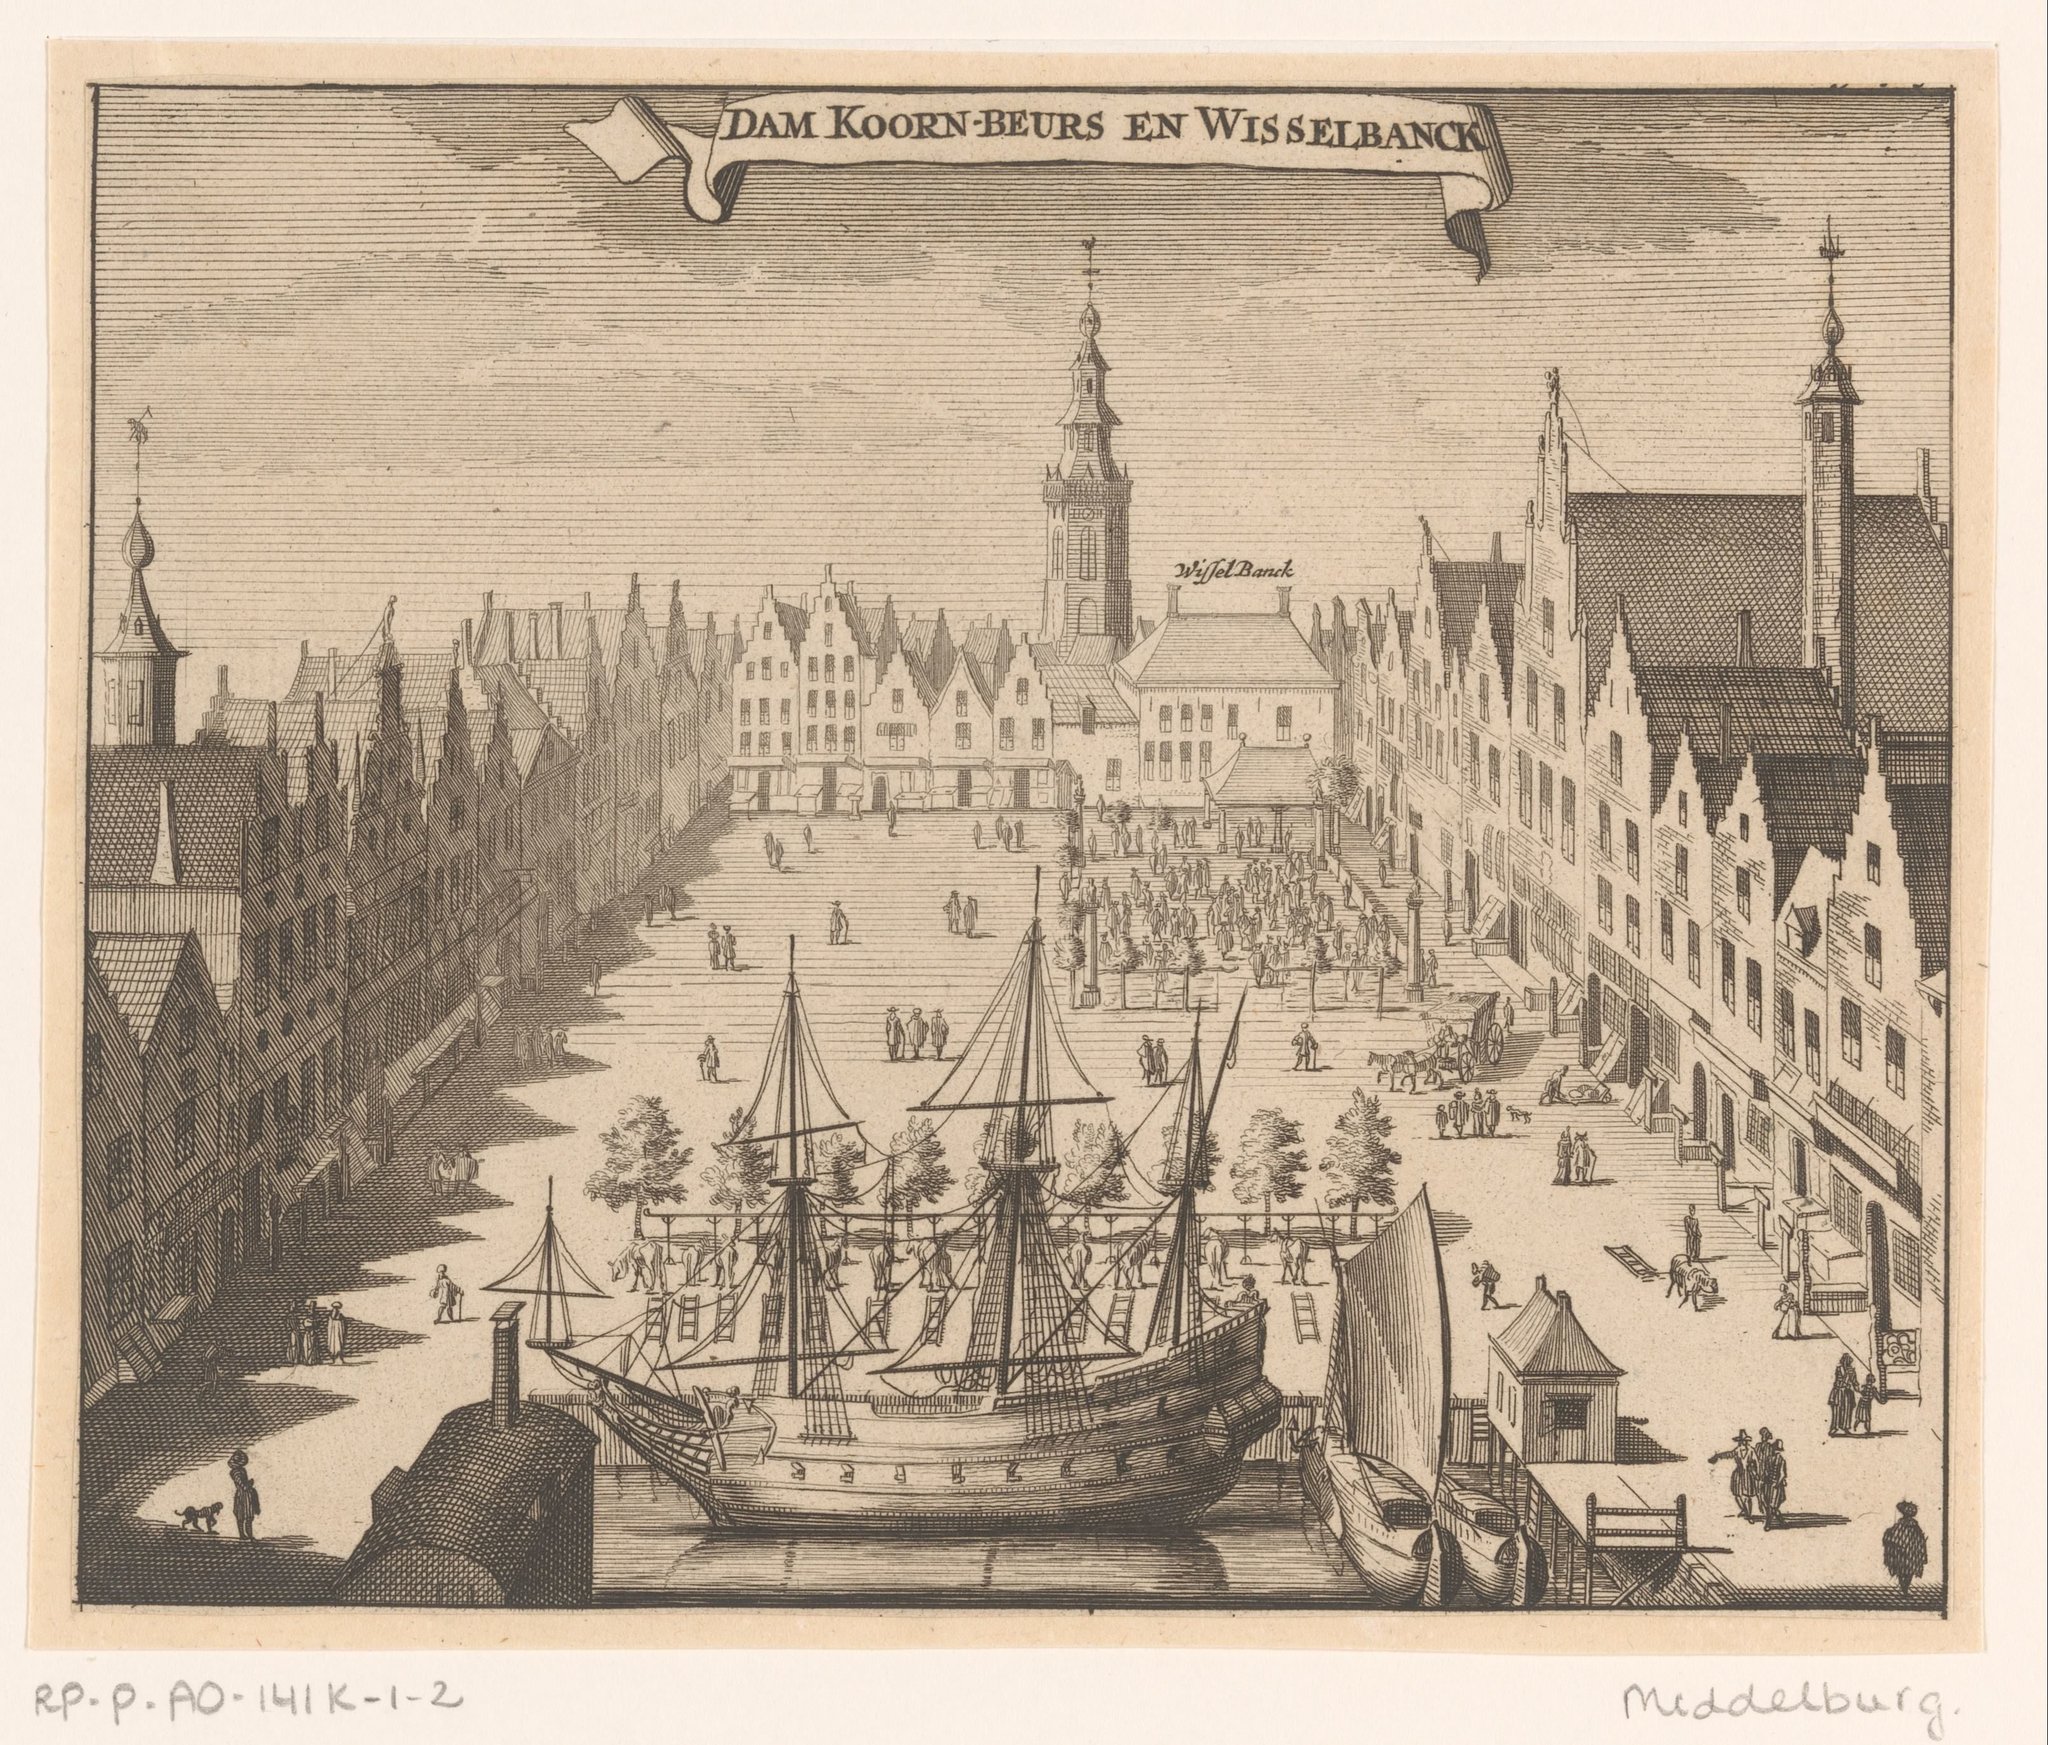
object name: print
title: Dam Koorn-beurs en Wisselbanck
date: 1696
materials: paper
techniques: engraving, etching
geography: middelburg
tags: sailing-ship, sailing-boat, stock exchange, stock-market, bank, square, place, circus, etc. (+ city(-scape) with figures, staffage), parts of church exterior and annexes: tower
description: Oorspronkelijk van één plaat gedrukt met drie andere voorstellingen (zie RP-P-AO-15-141L-2-2, RP-P-AO-15-141M-2-2 en RP-P-AO-15-141N-1-2). Prent in zijn geheel ook gebruikt in: Smallegange, Mattheus. Nieuwe Cronyk van Zeeland (…). Middelburg en Amsterdam: Johannes Meertens en Abraham van Someren, 1696. Huidige voorstelling later (plaat mogelijk versneden) met één andere voorstelling van zelfde plaat, één andere voorstelling van andere plaat en apart gedrukte sierrand ook gebruikt in: Aa, Pieter van der. La galerie agreable du monde (...). 66 delen. Leiden: Pieter van der Aa, 1728, dl. 20.